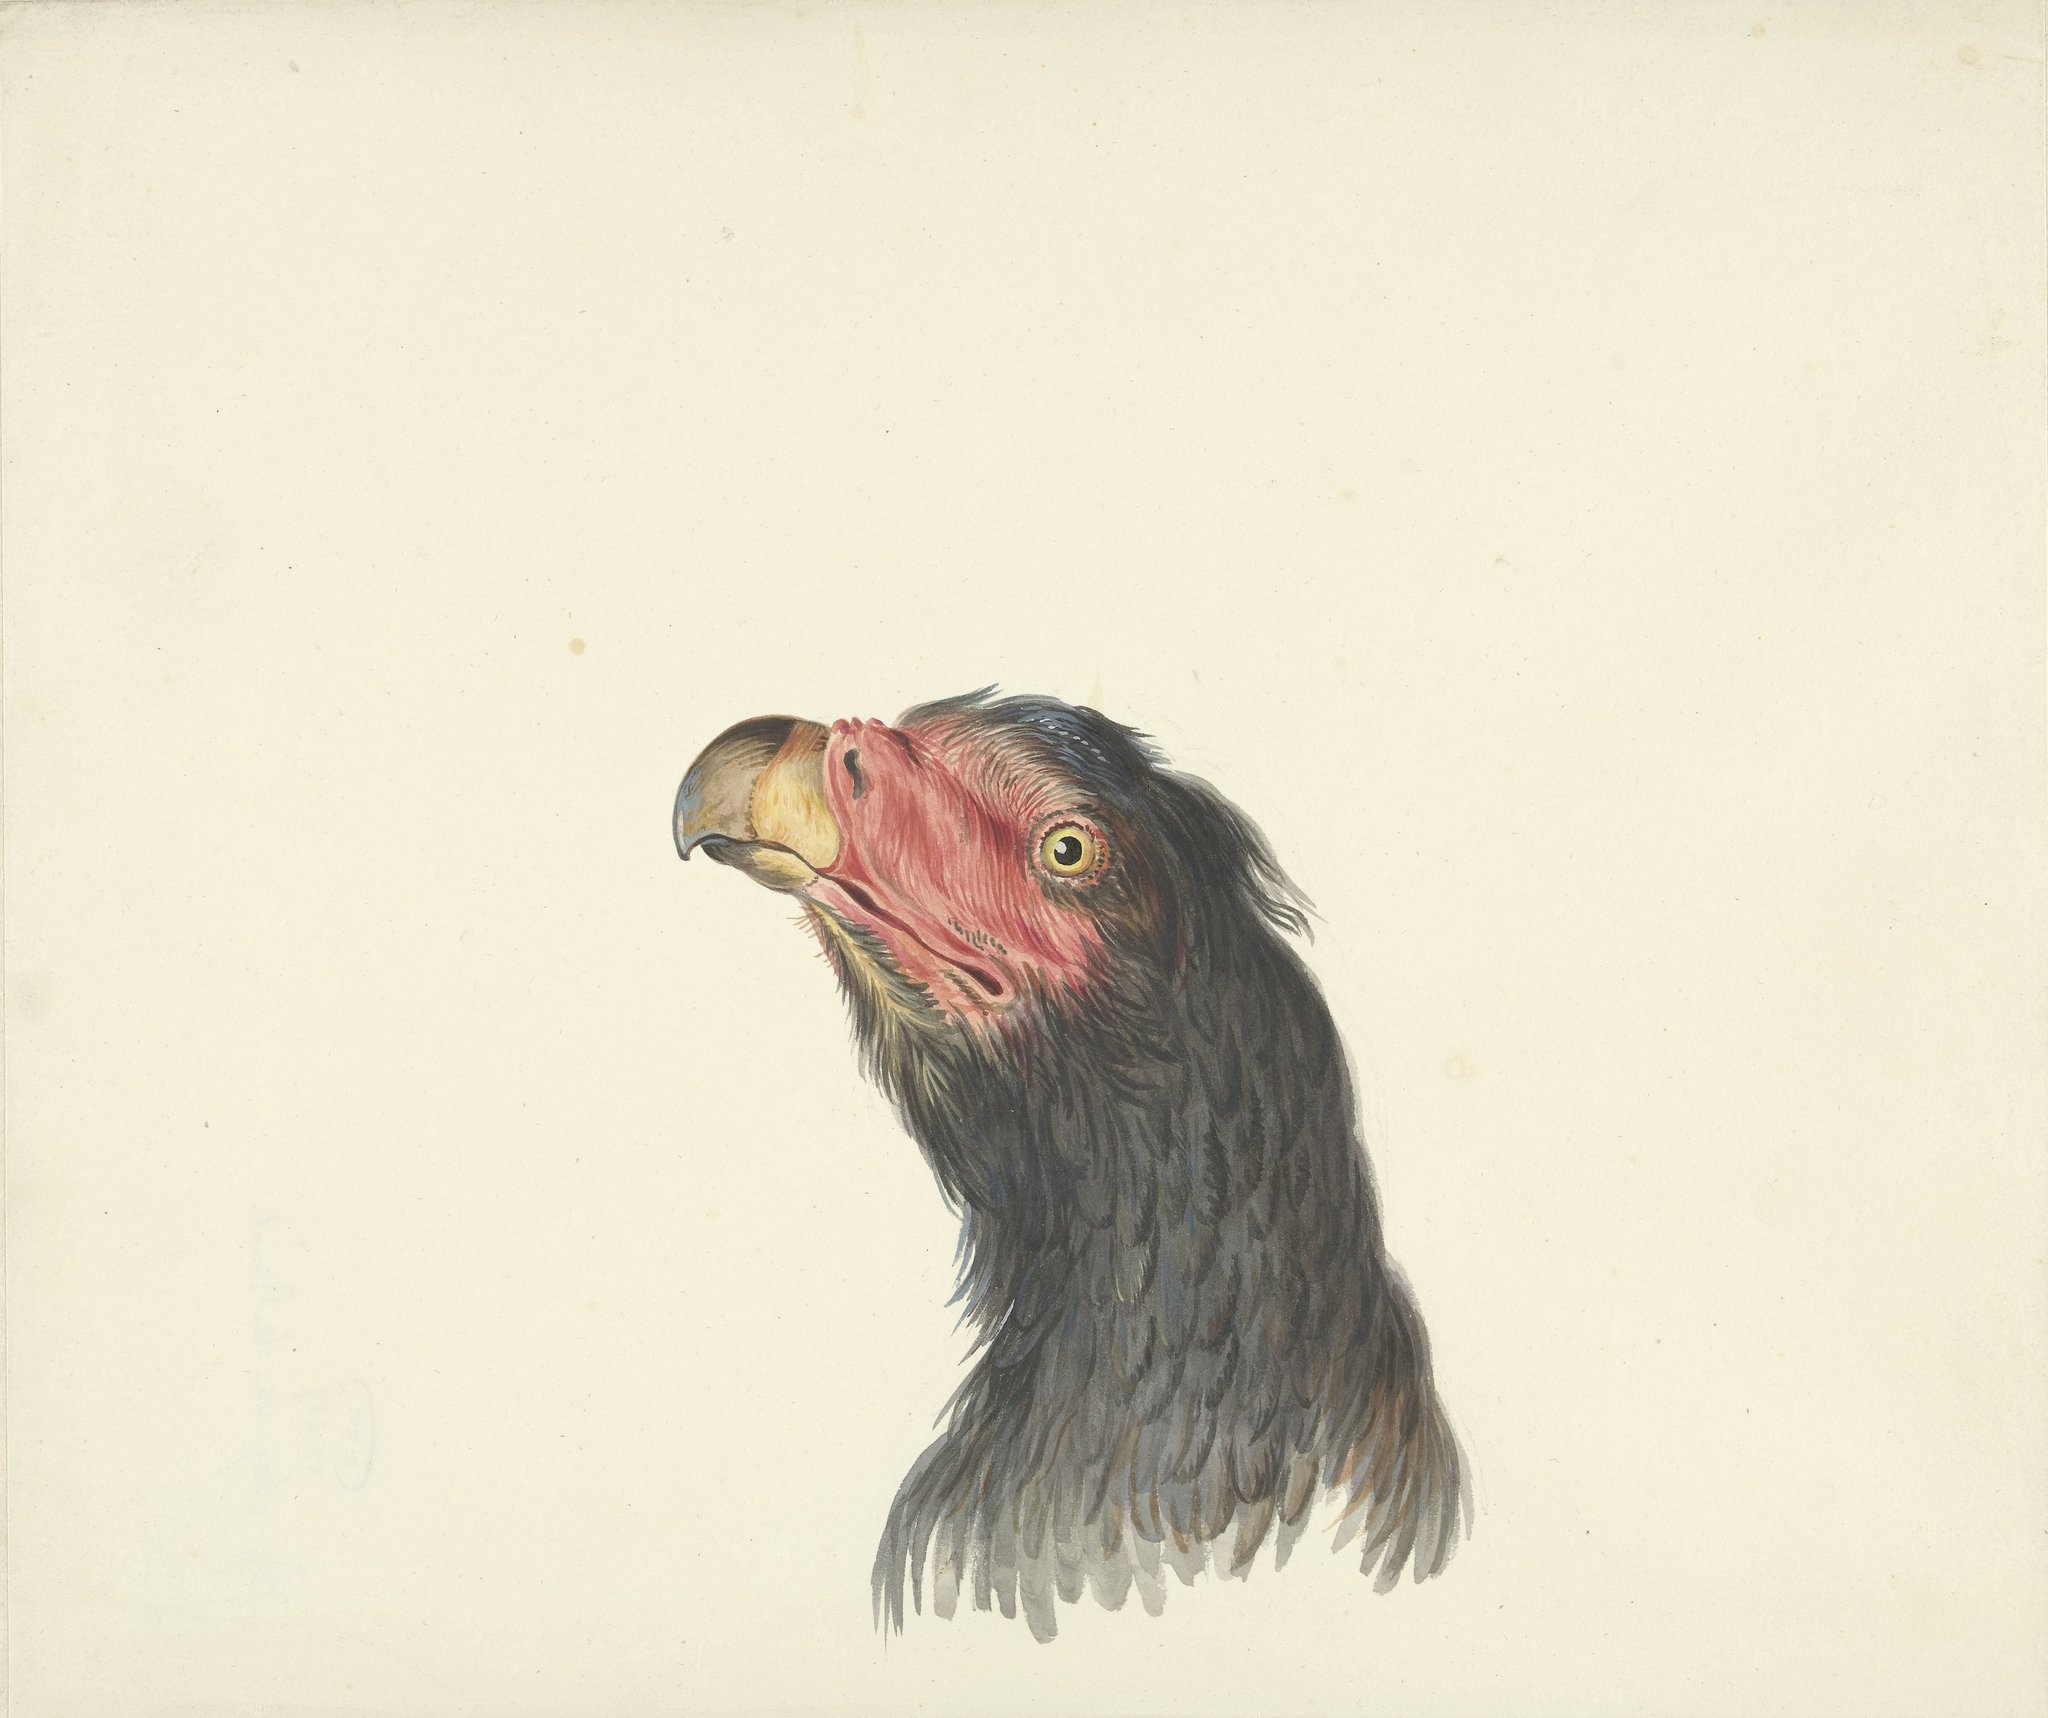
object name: watercolor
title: Kop van een gier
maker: françois levaillant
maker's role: draughtsman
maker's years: 1753-1824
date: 1763-1824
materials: paper, watercolor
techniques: brush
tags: predatory birds: vulture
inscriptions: collector's mark: Lugt 2228